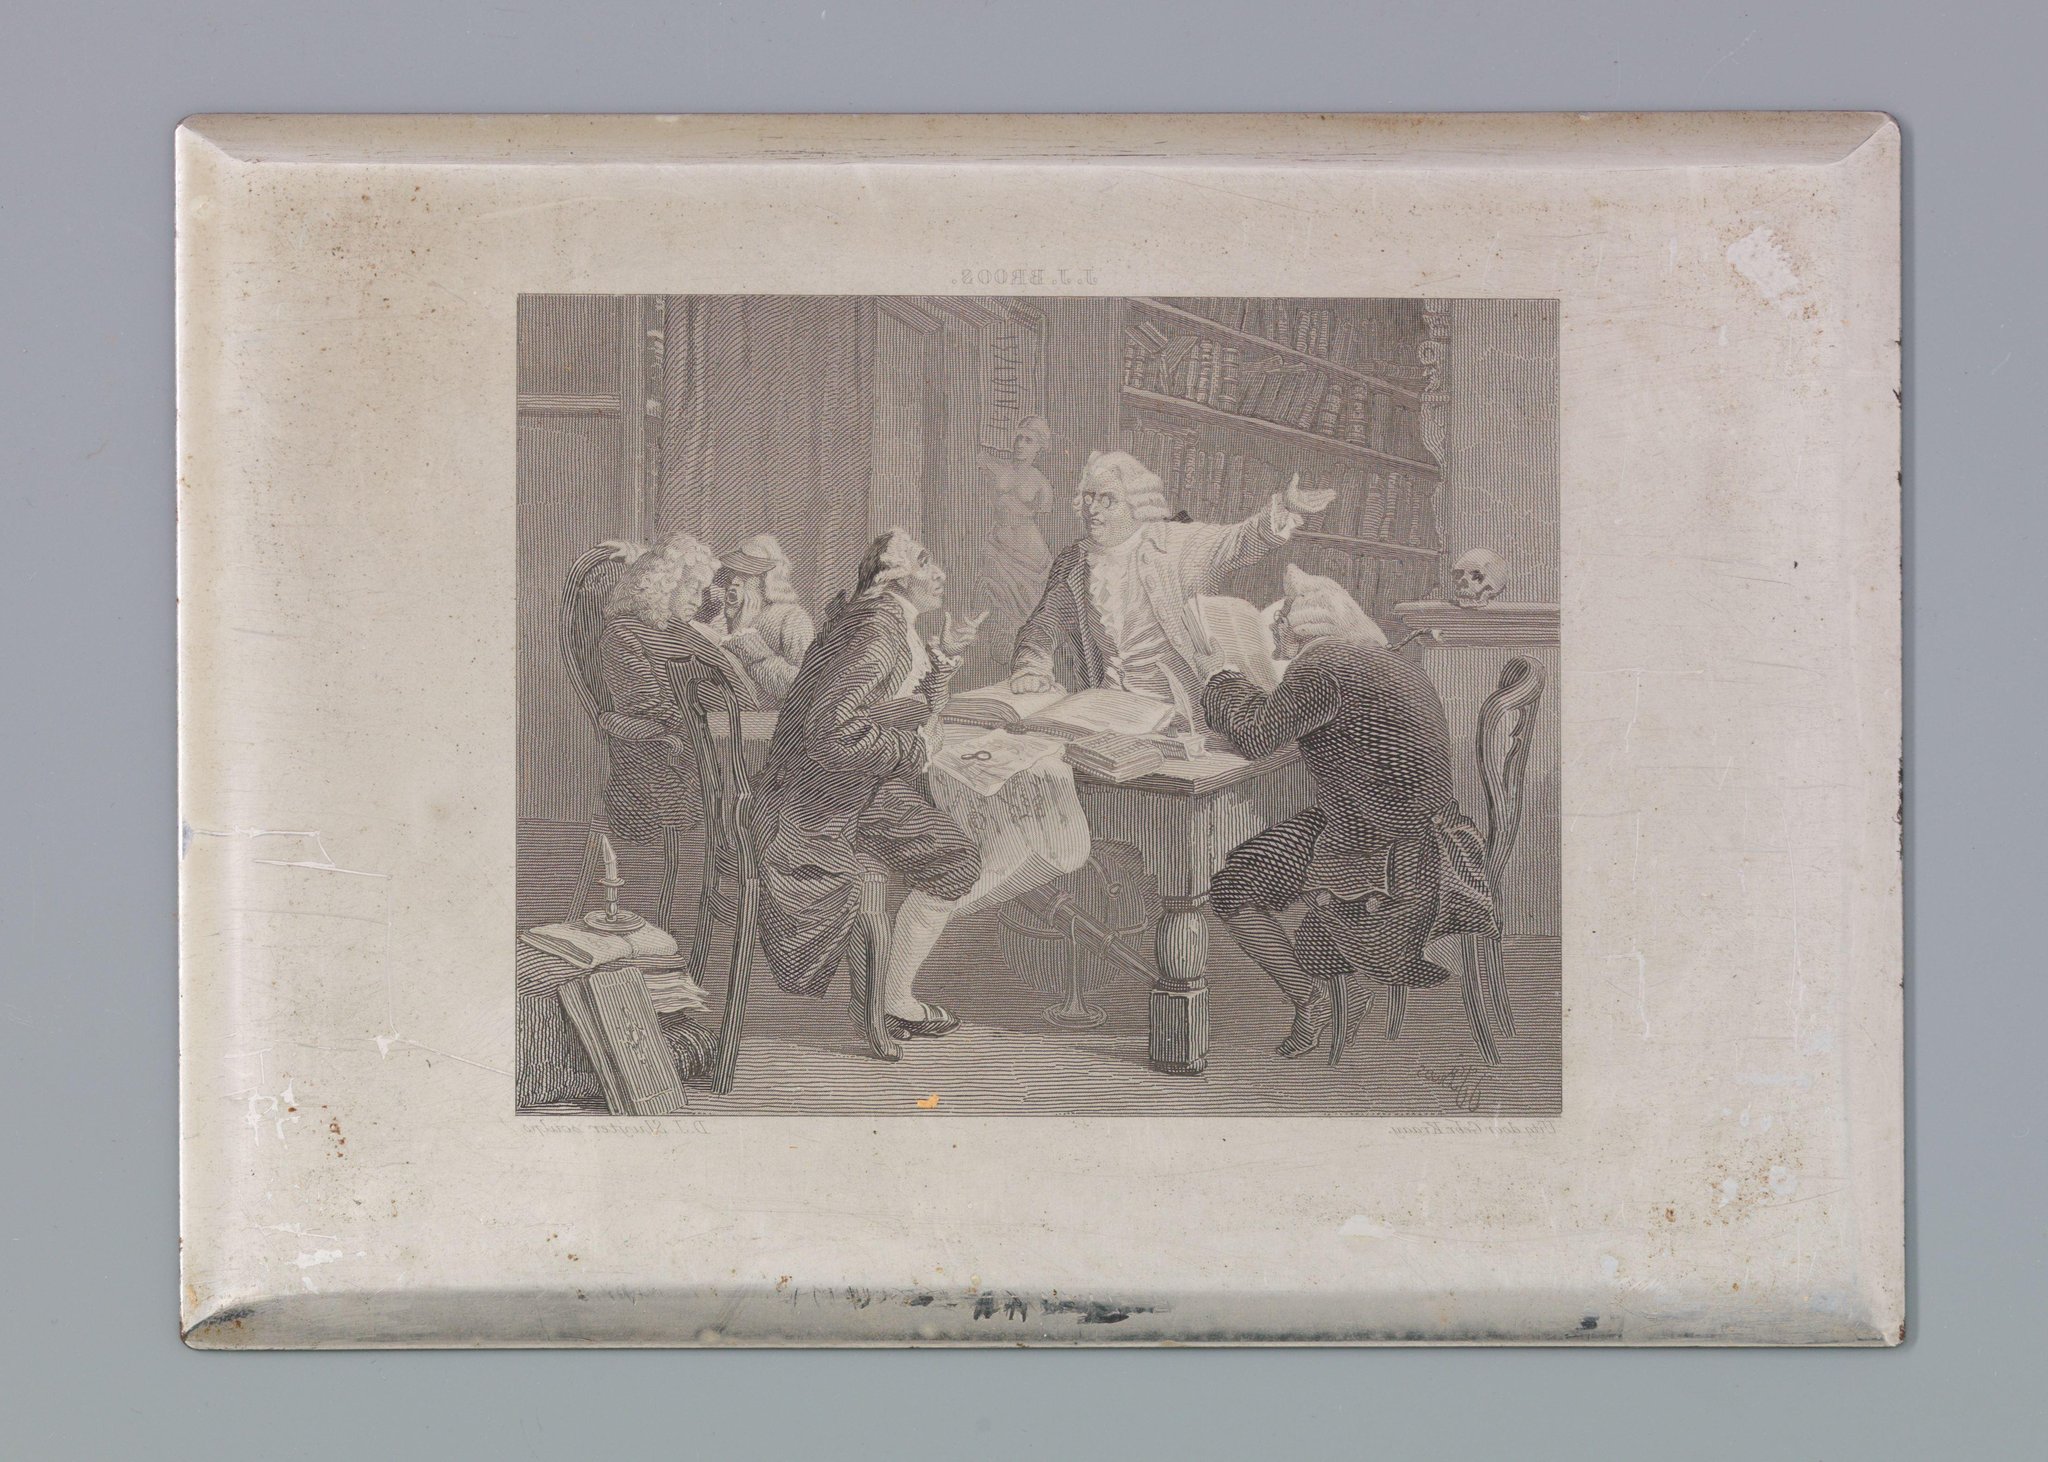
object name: staalplaat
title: Vijf geleerden rond een tafel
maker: dirk jurriaan sluyter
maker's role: draughtsman, print maker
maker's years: 1811-1886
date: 1811-1886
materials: steel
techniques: engraving